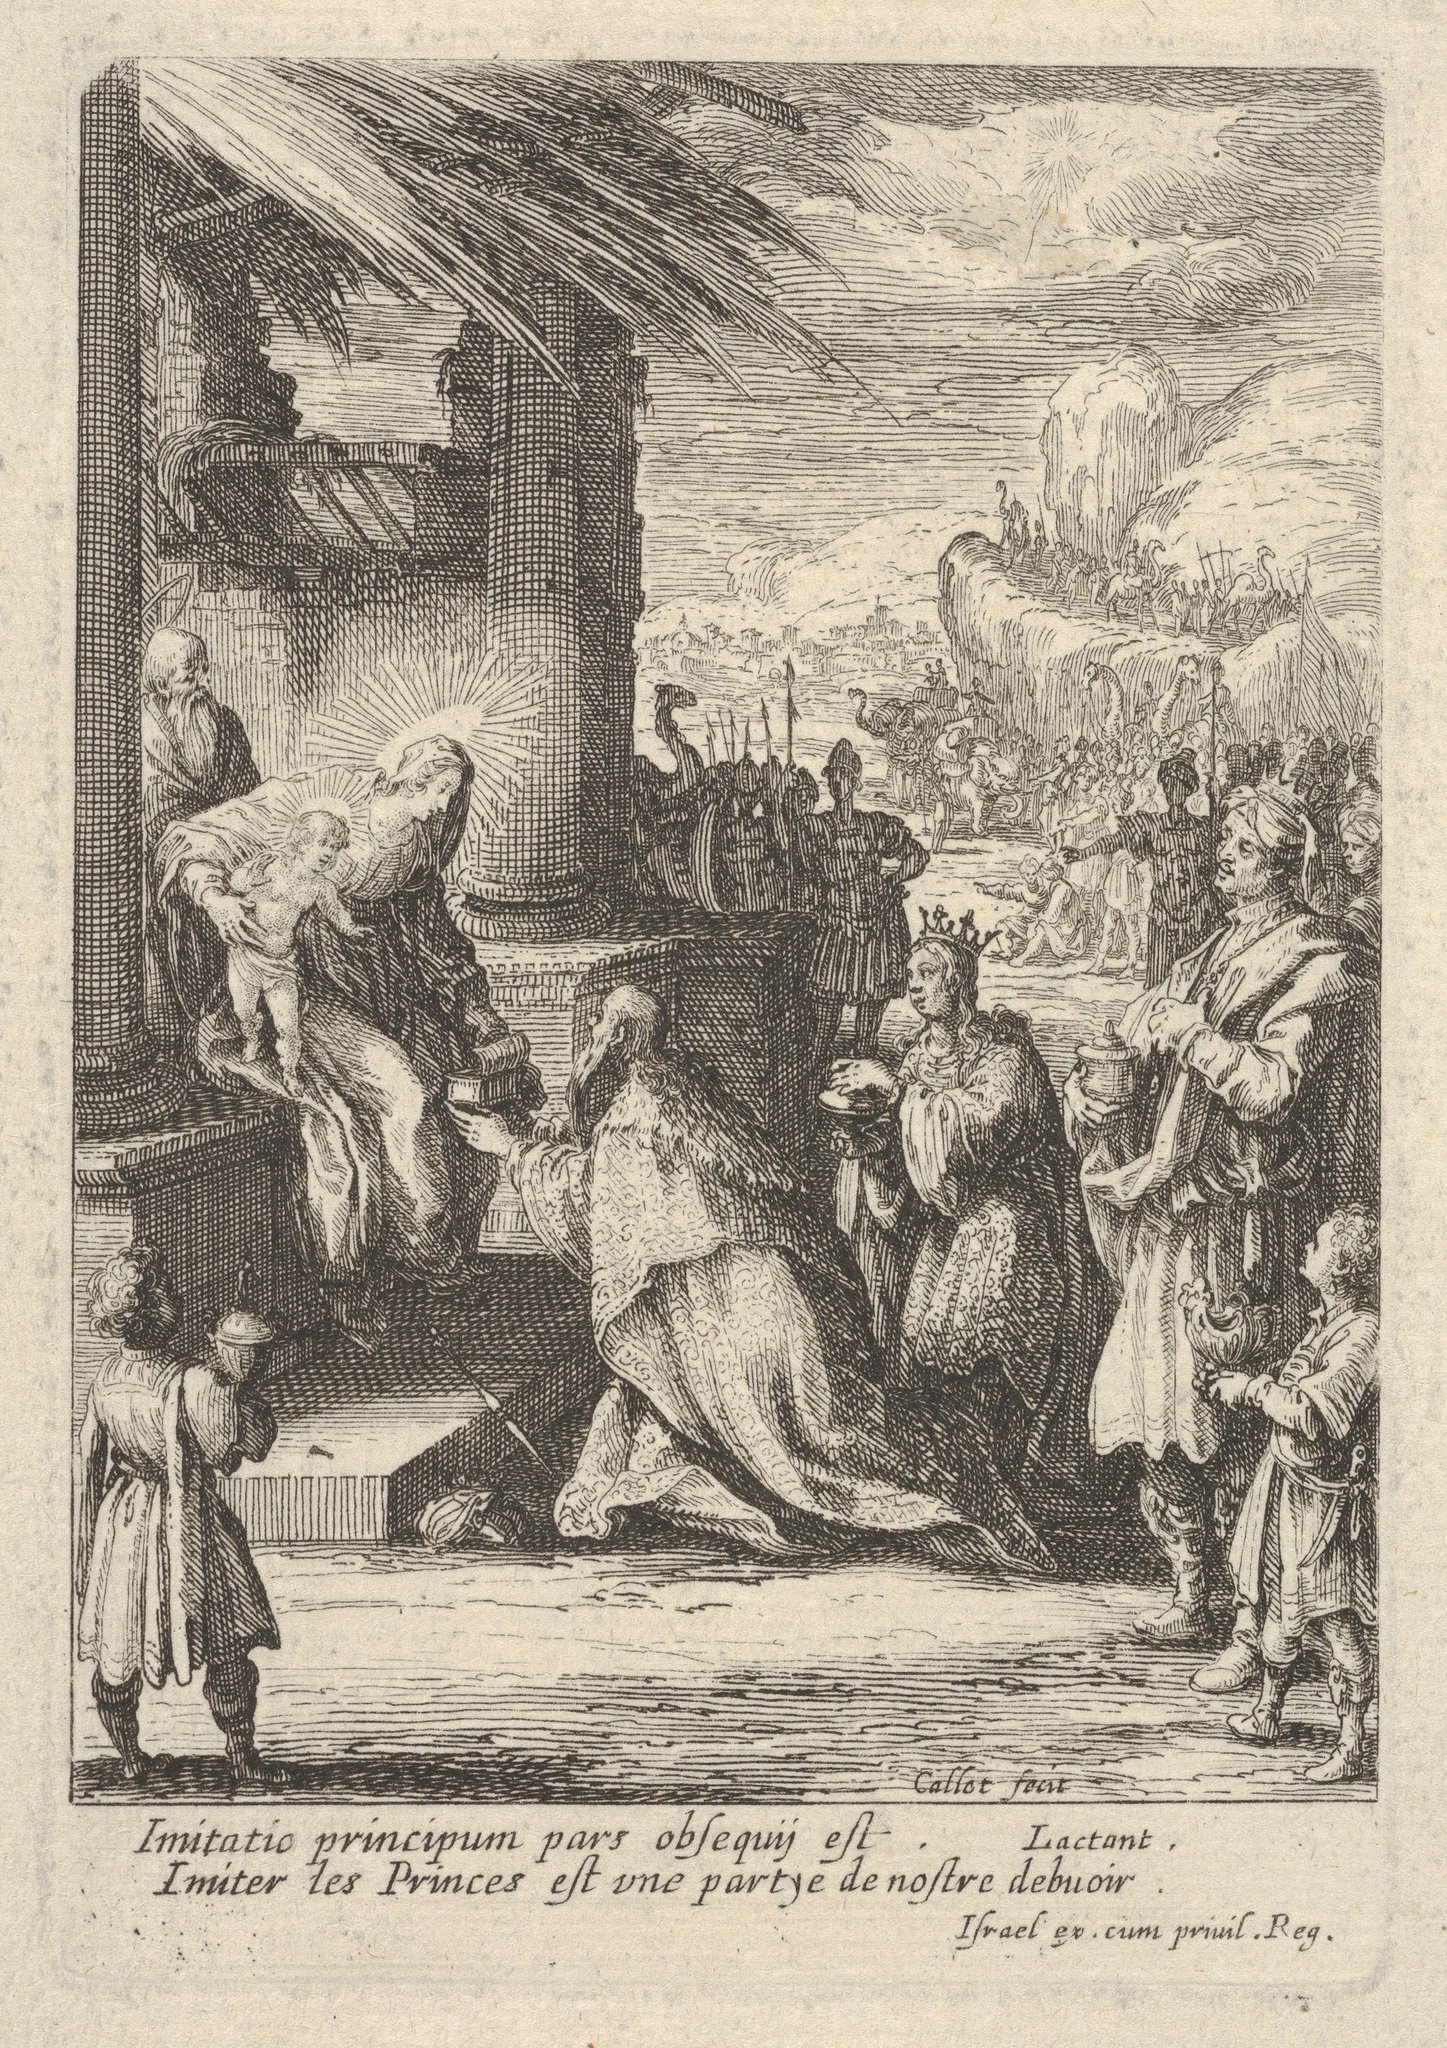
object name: print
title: Adoration of the Magi, with Mary bracing Jesus with her right hand and reaching for a gift with her left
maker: jacques callot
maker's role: artist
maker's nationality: french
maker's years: 1592-1635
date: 1621-1635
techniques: etching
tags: men,christ,virgin mary,adoration of the magi